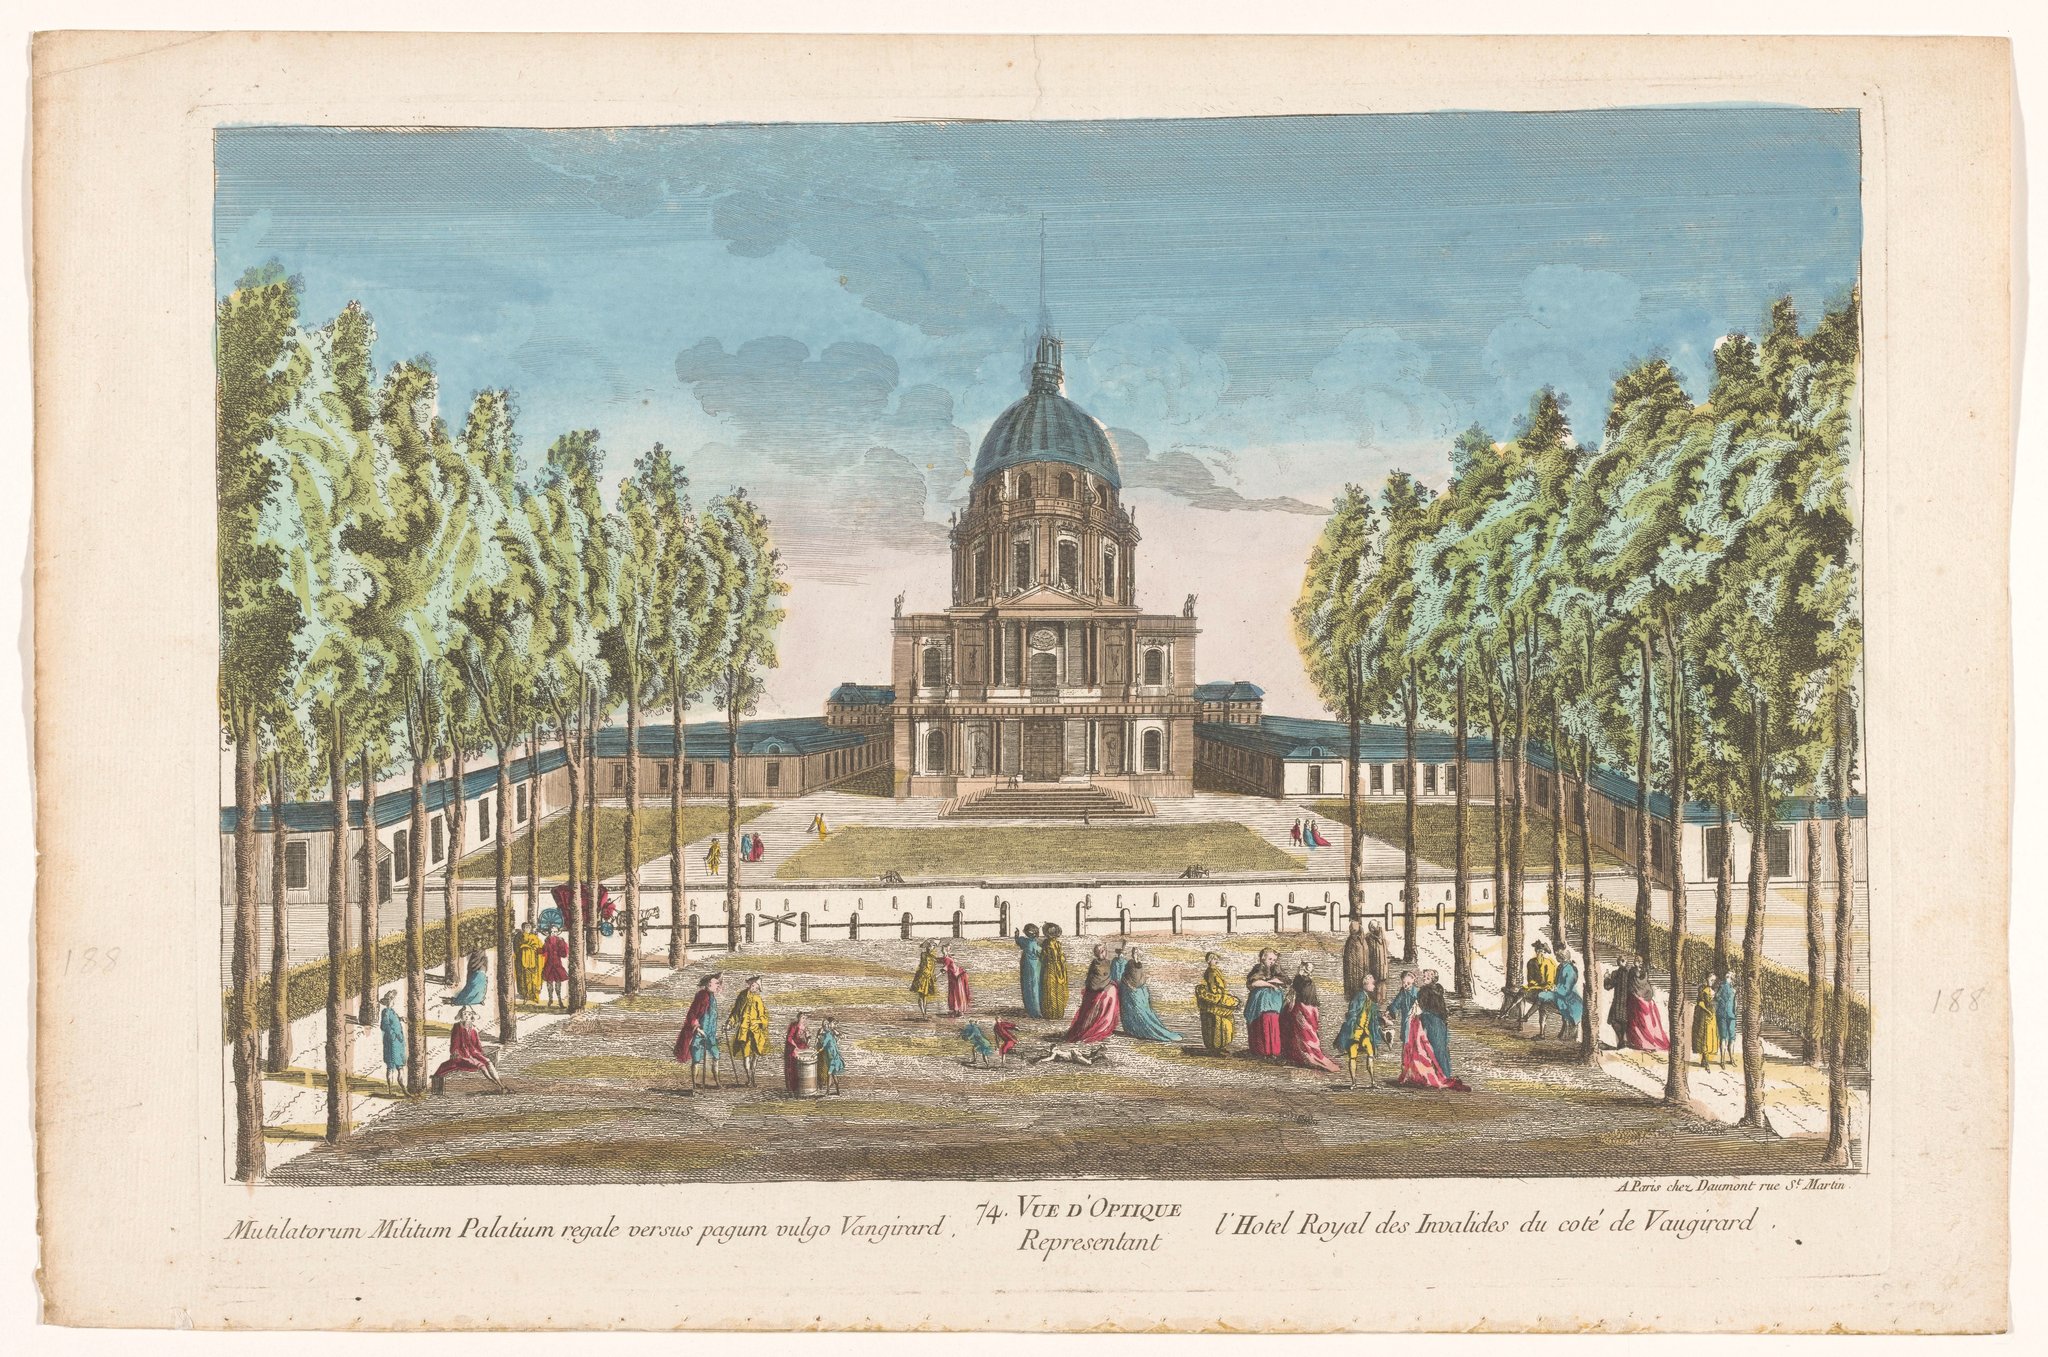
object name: print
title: Gezicht op het Hôtel des Invalides te Parijs gezien vanaf de wijk Vaugirard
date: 1745-1775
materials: paper, watercolor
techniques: brush, etching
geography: france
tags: civic architecture; edifices; dwellings, street (+ city(-scape) with figures, staffage)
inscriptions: watermark, collector's mark: Lugt 2166